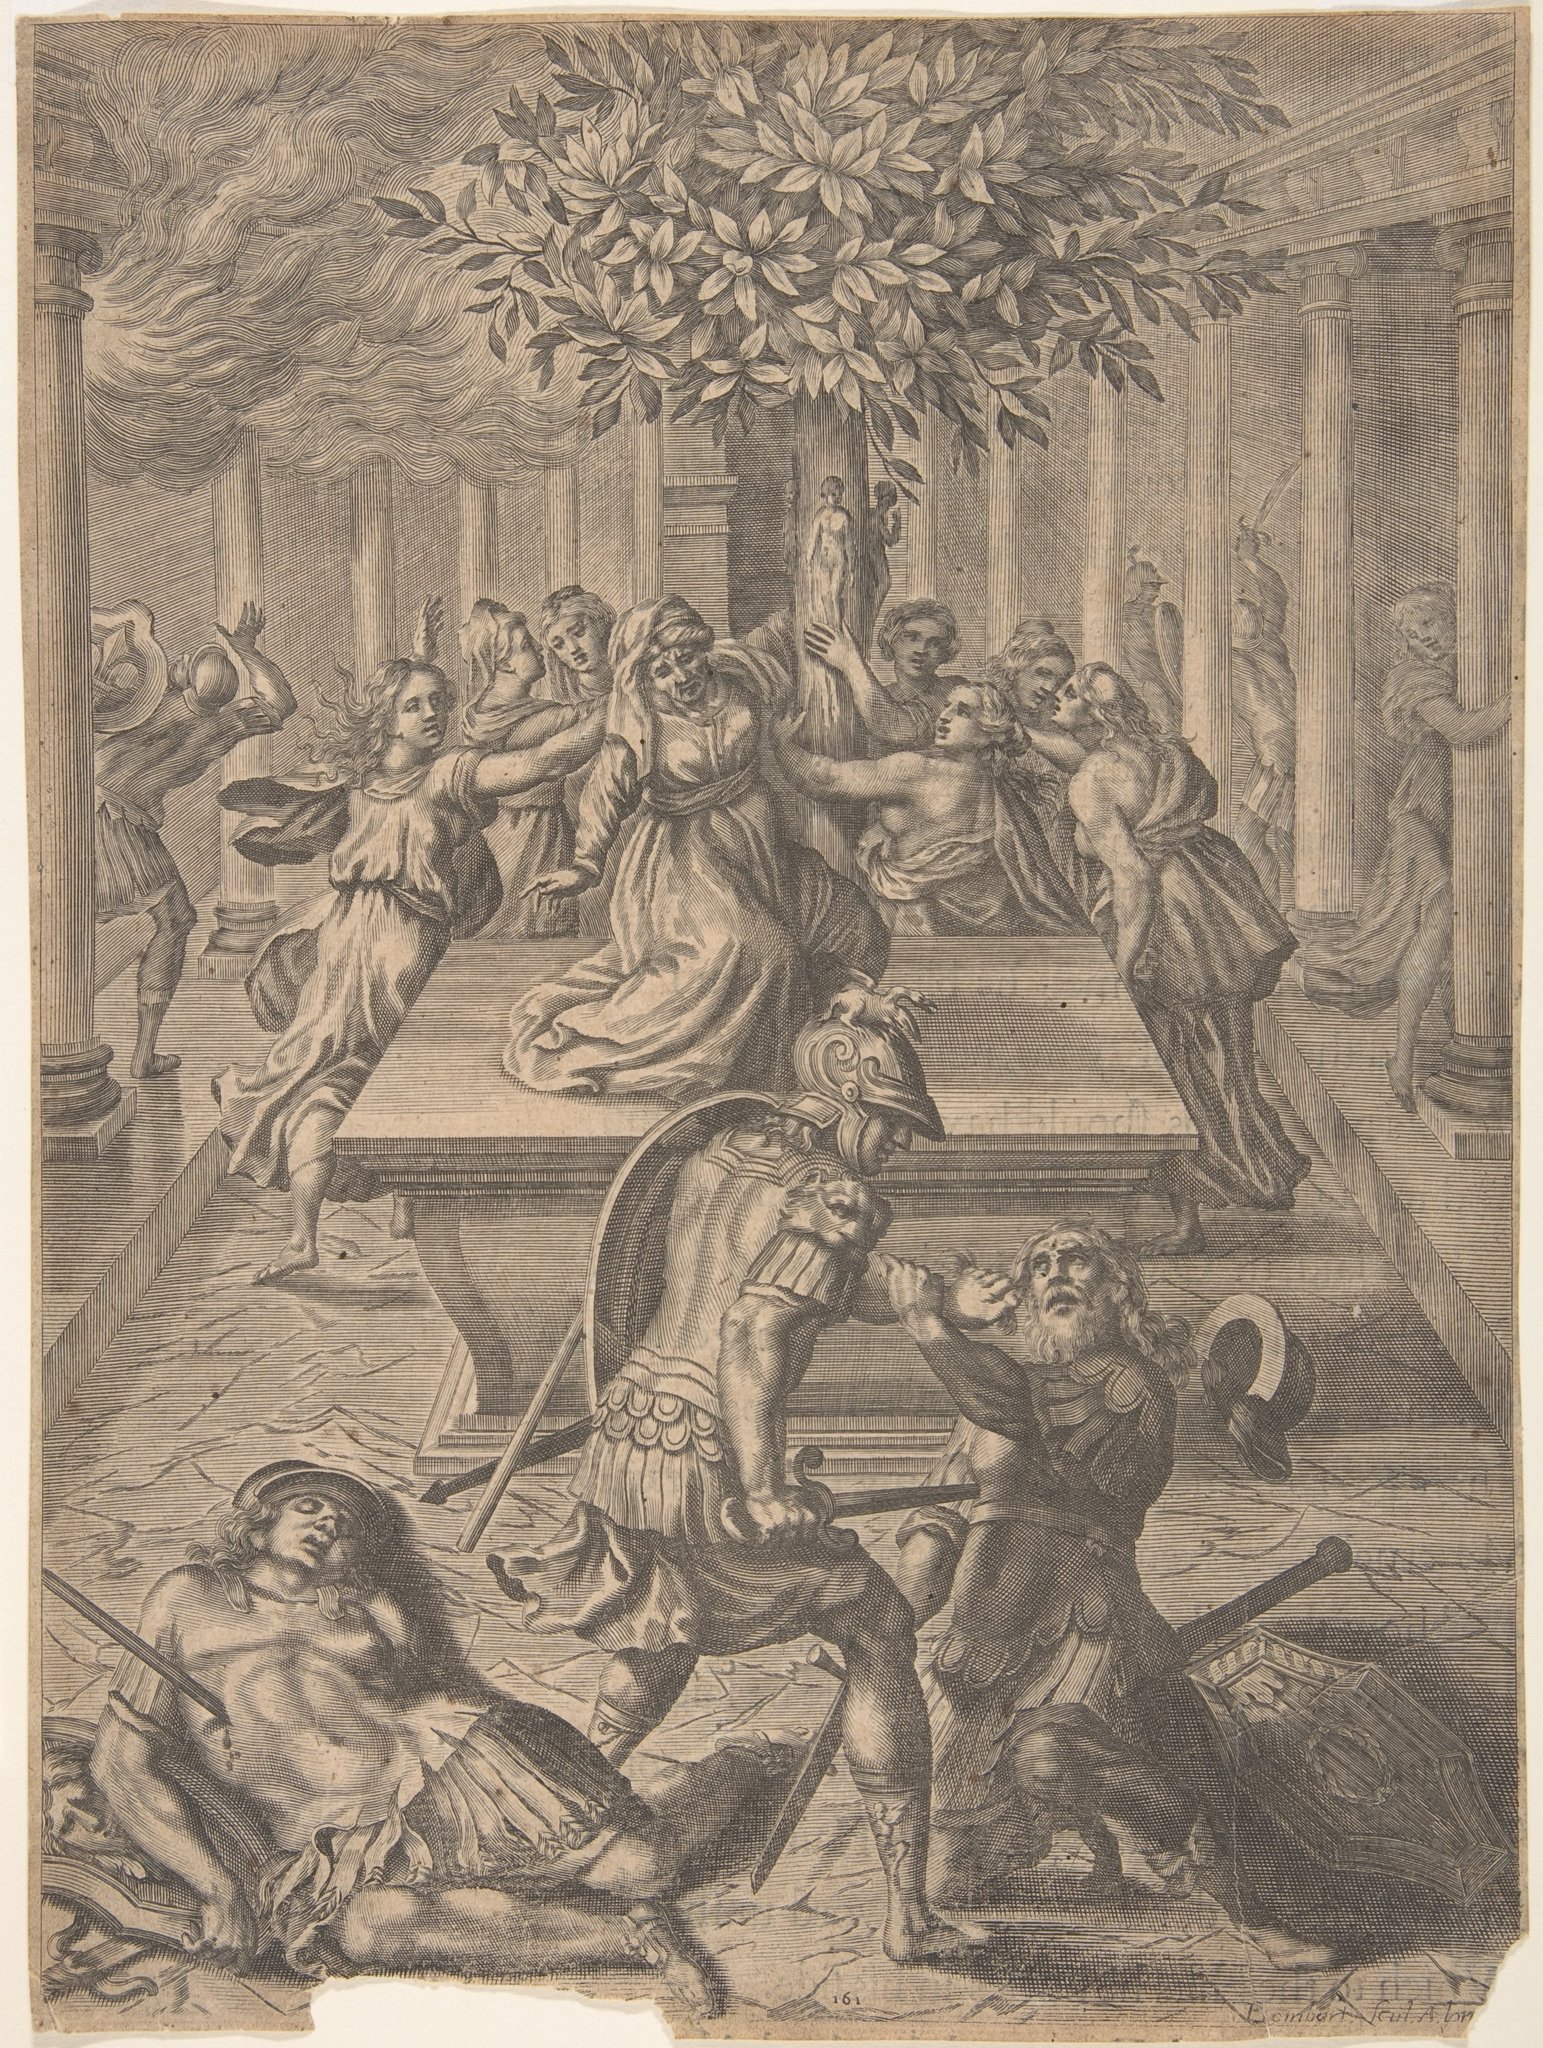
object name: print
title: The Sack of Troy–Pyrrhus Killing Priam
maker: pierre lombart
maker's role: artist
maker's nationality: french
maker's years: 1612-1682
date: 1654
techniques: engraving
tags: kings,men,women,death,generals